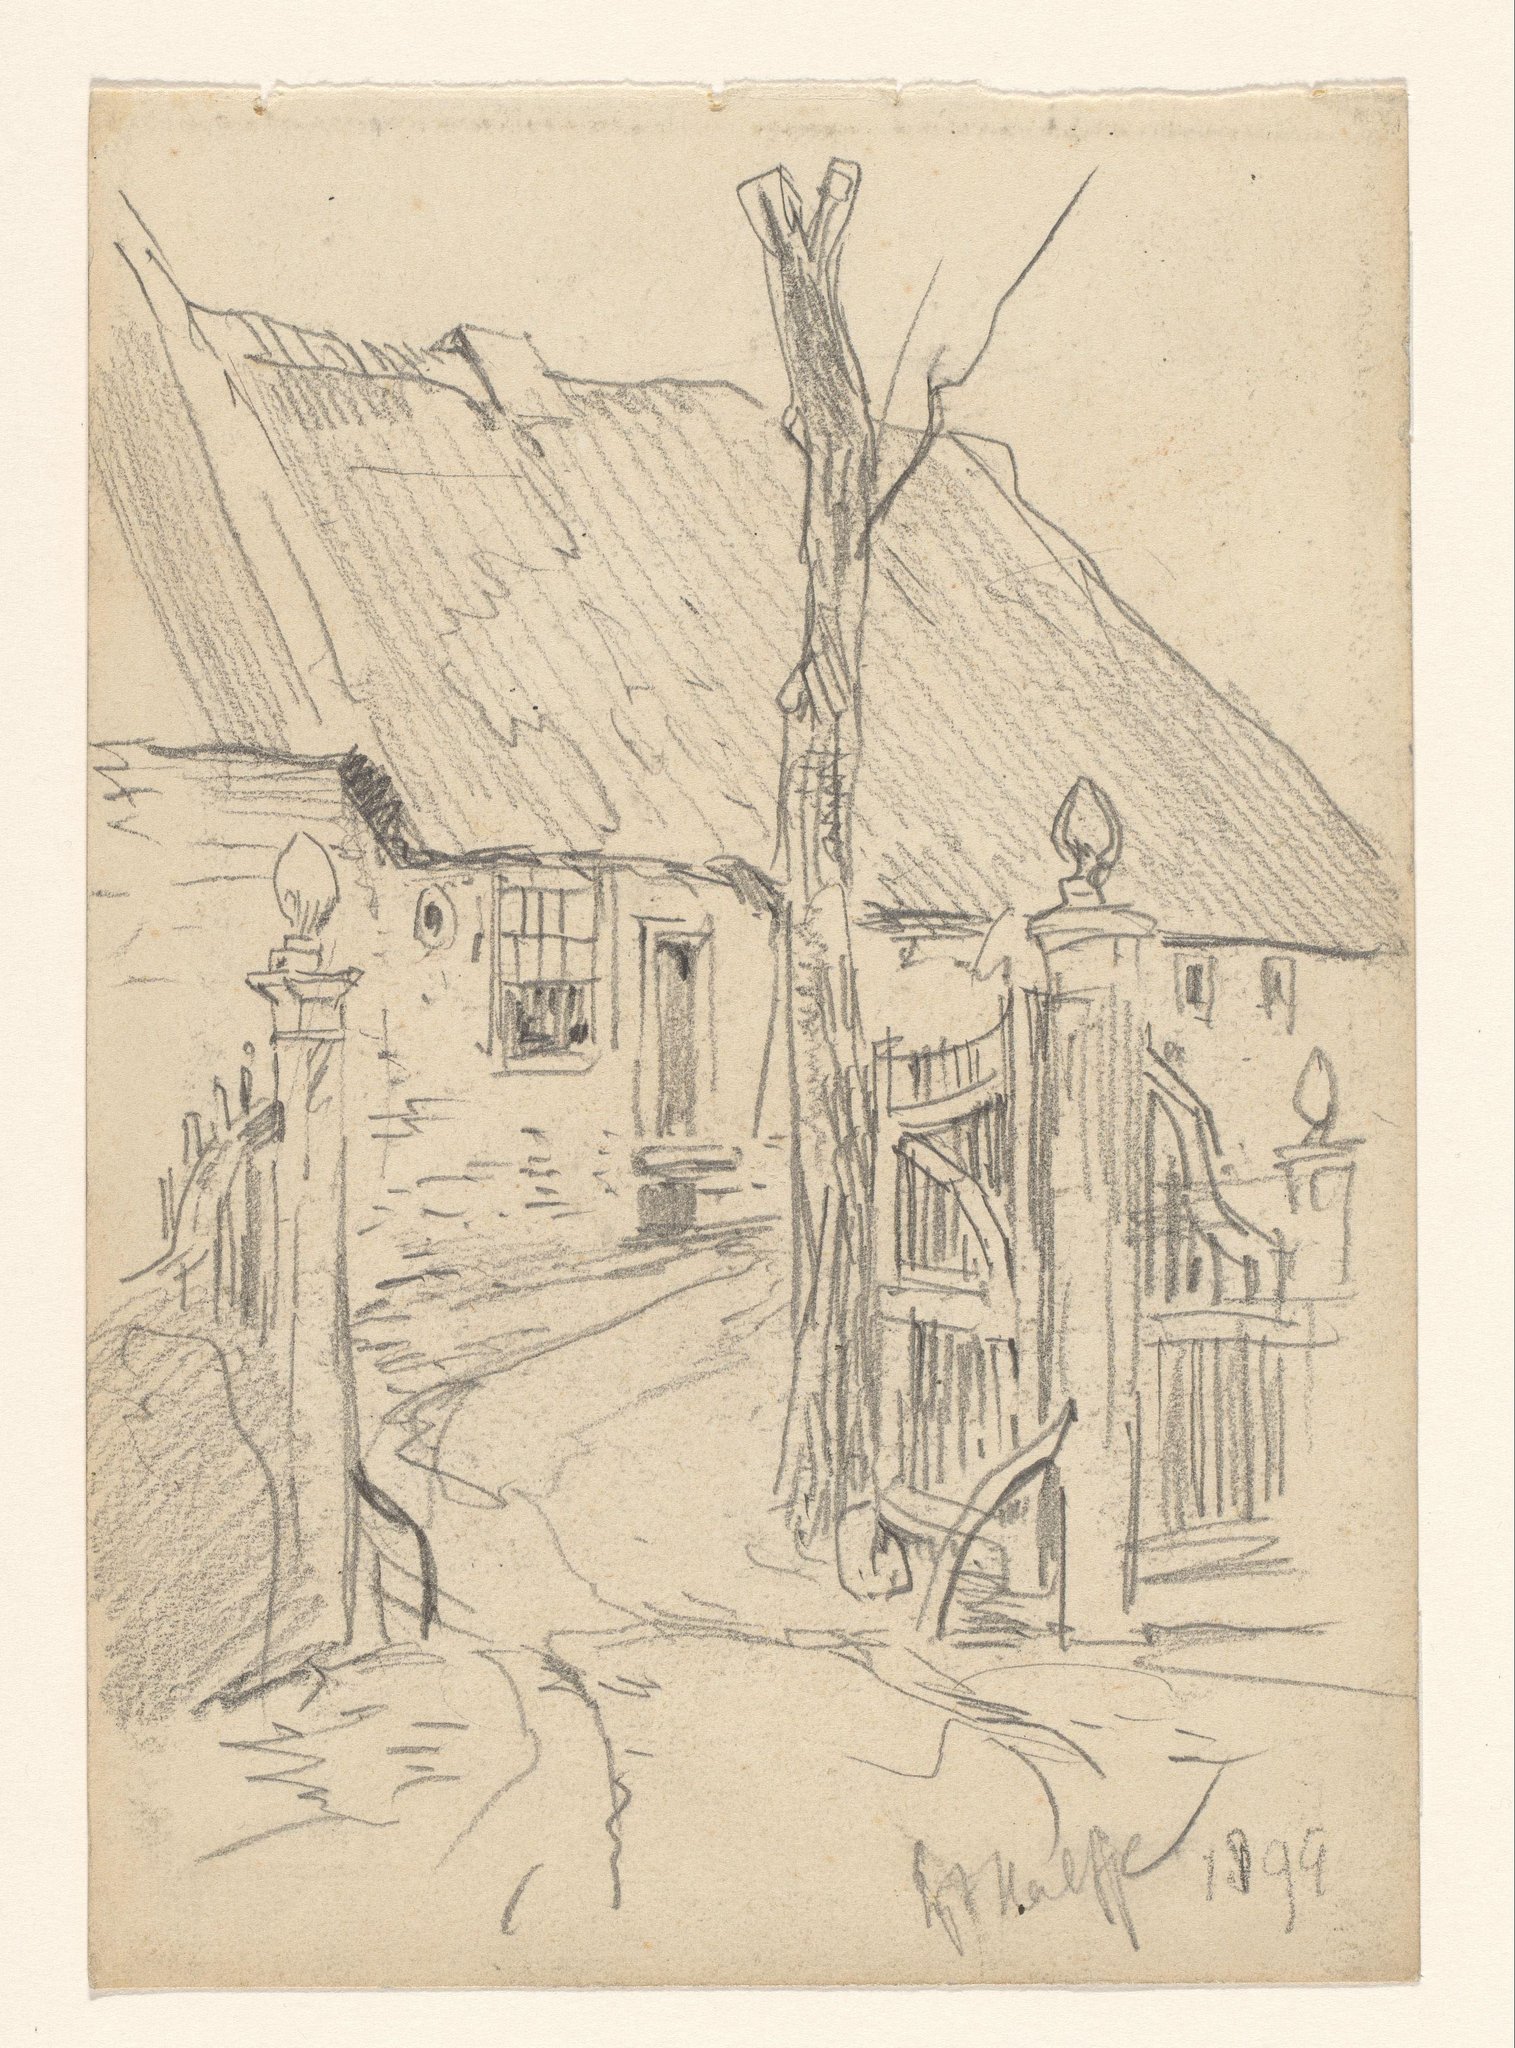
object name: drawing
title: Toegangshek van een boerderij bij 't Kalfje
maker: jan hoynck van papendrecht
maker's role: draughtsman, painter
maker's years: 1858-1933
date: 1894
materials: paper, pencil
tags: gate, entrance, farm (building)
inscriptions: collector's mark: Lugt 2228, annotation: ‘bij t Kalfje 1894’